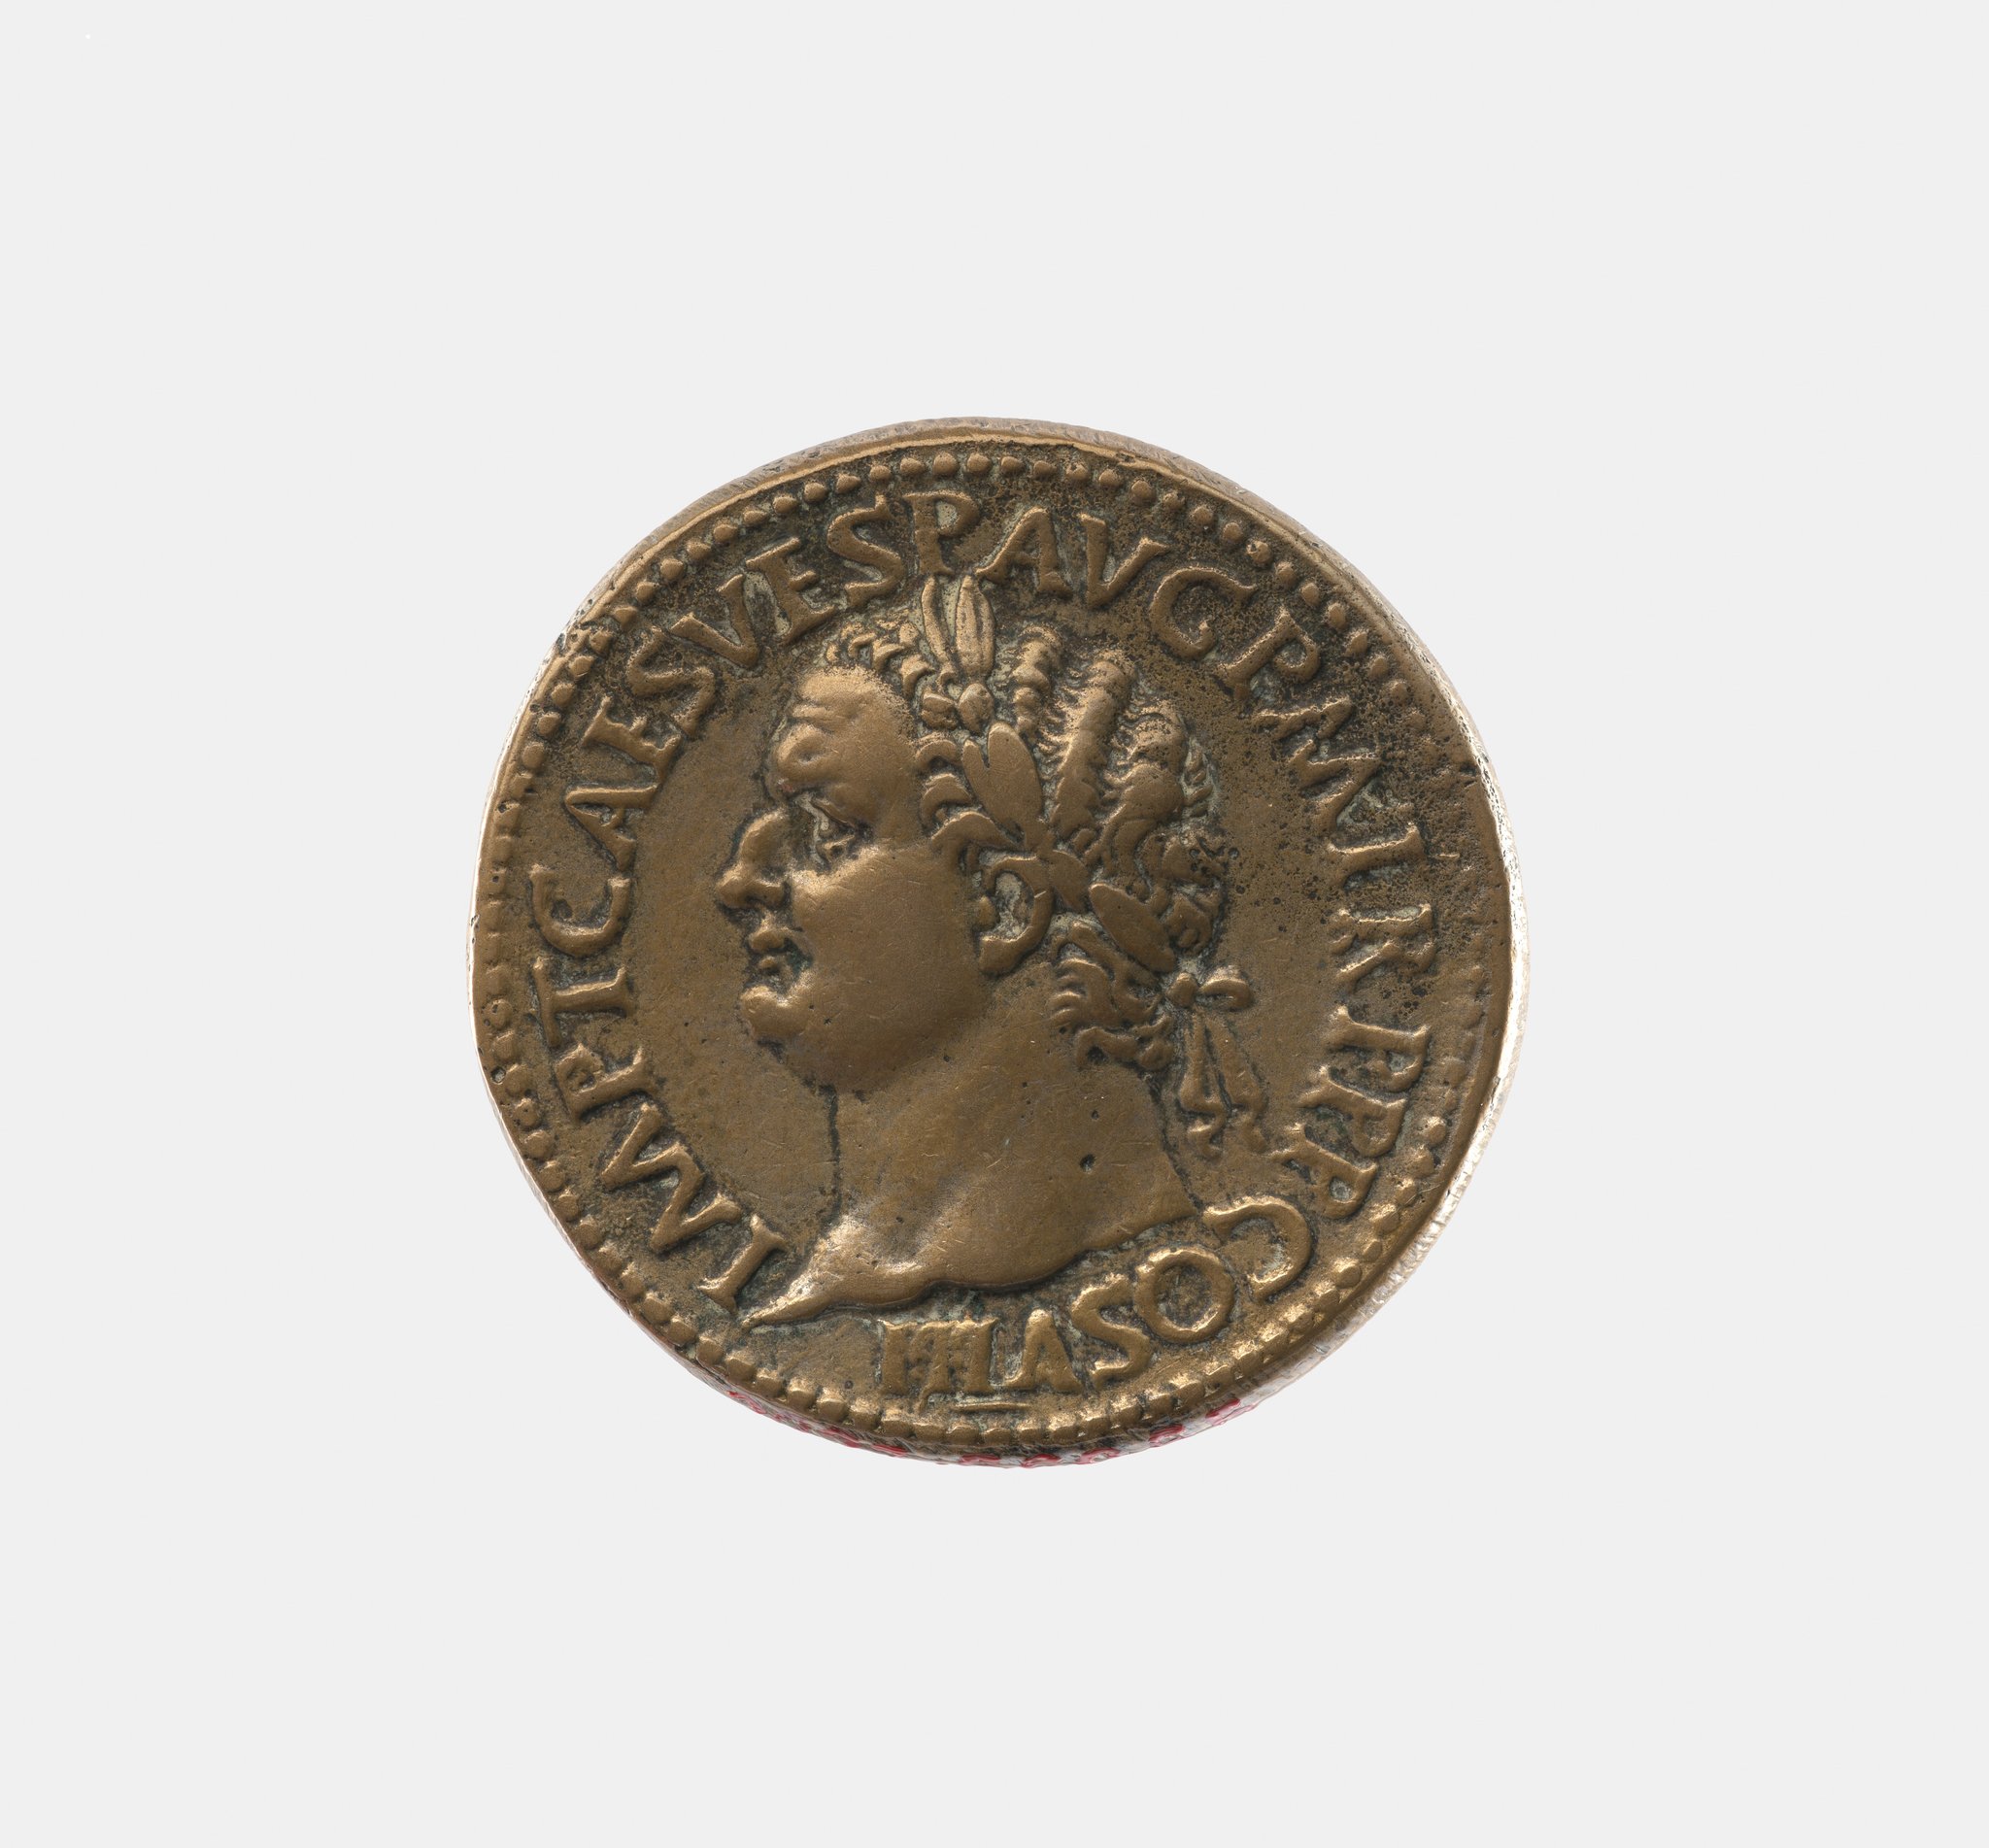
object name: medal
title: Emperor Titus A.D. 79-81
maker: giovanni del cavino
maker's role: artist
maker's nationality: italian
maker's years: 1500-1570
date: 1500-1570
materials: bronze